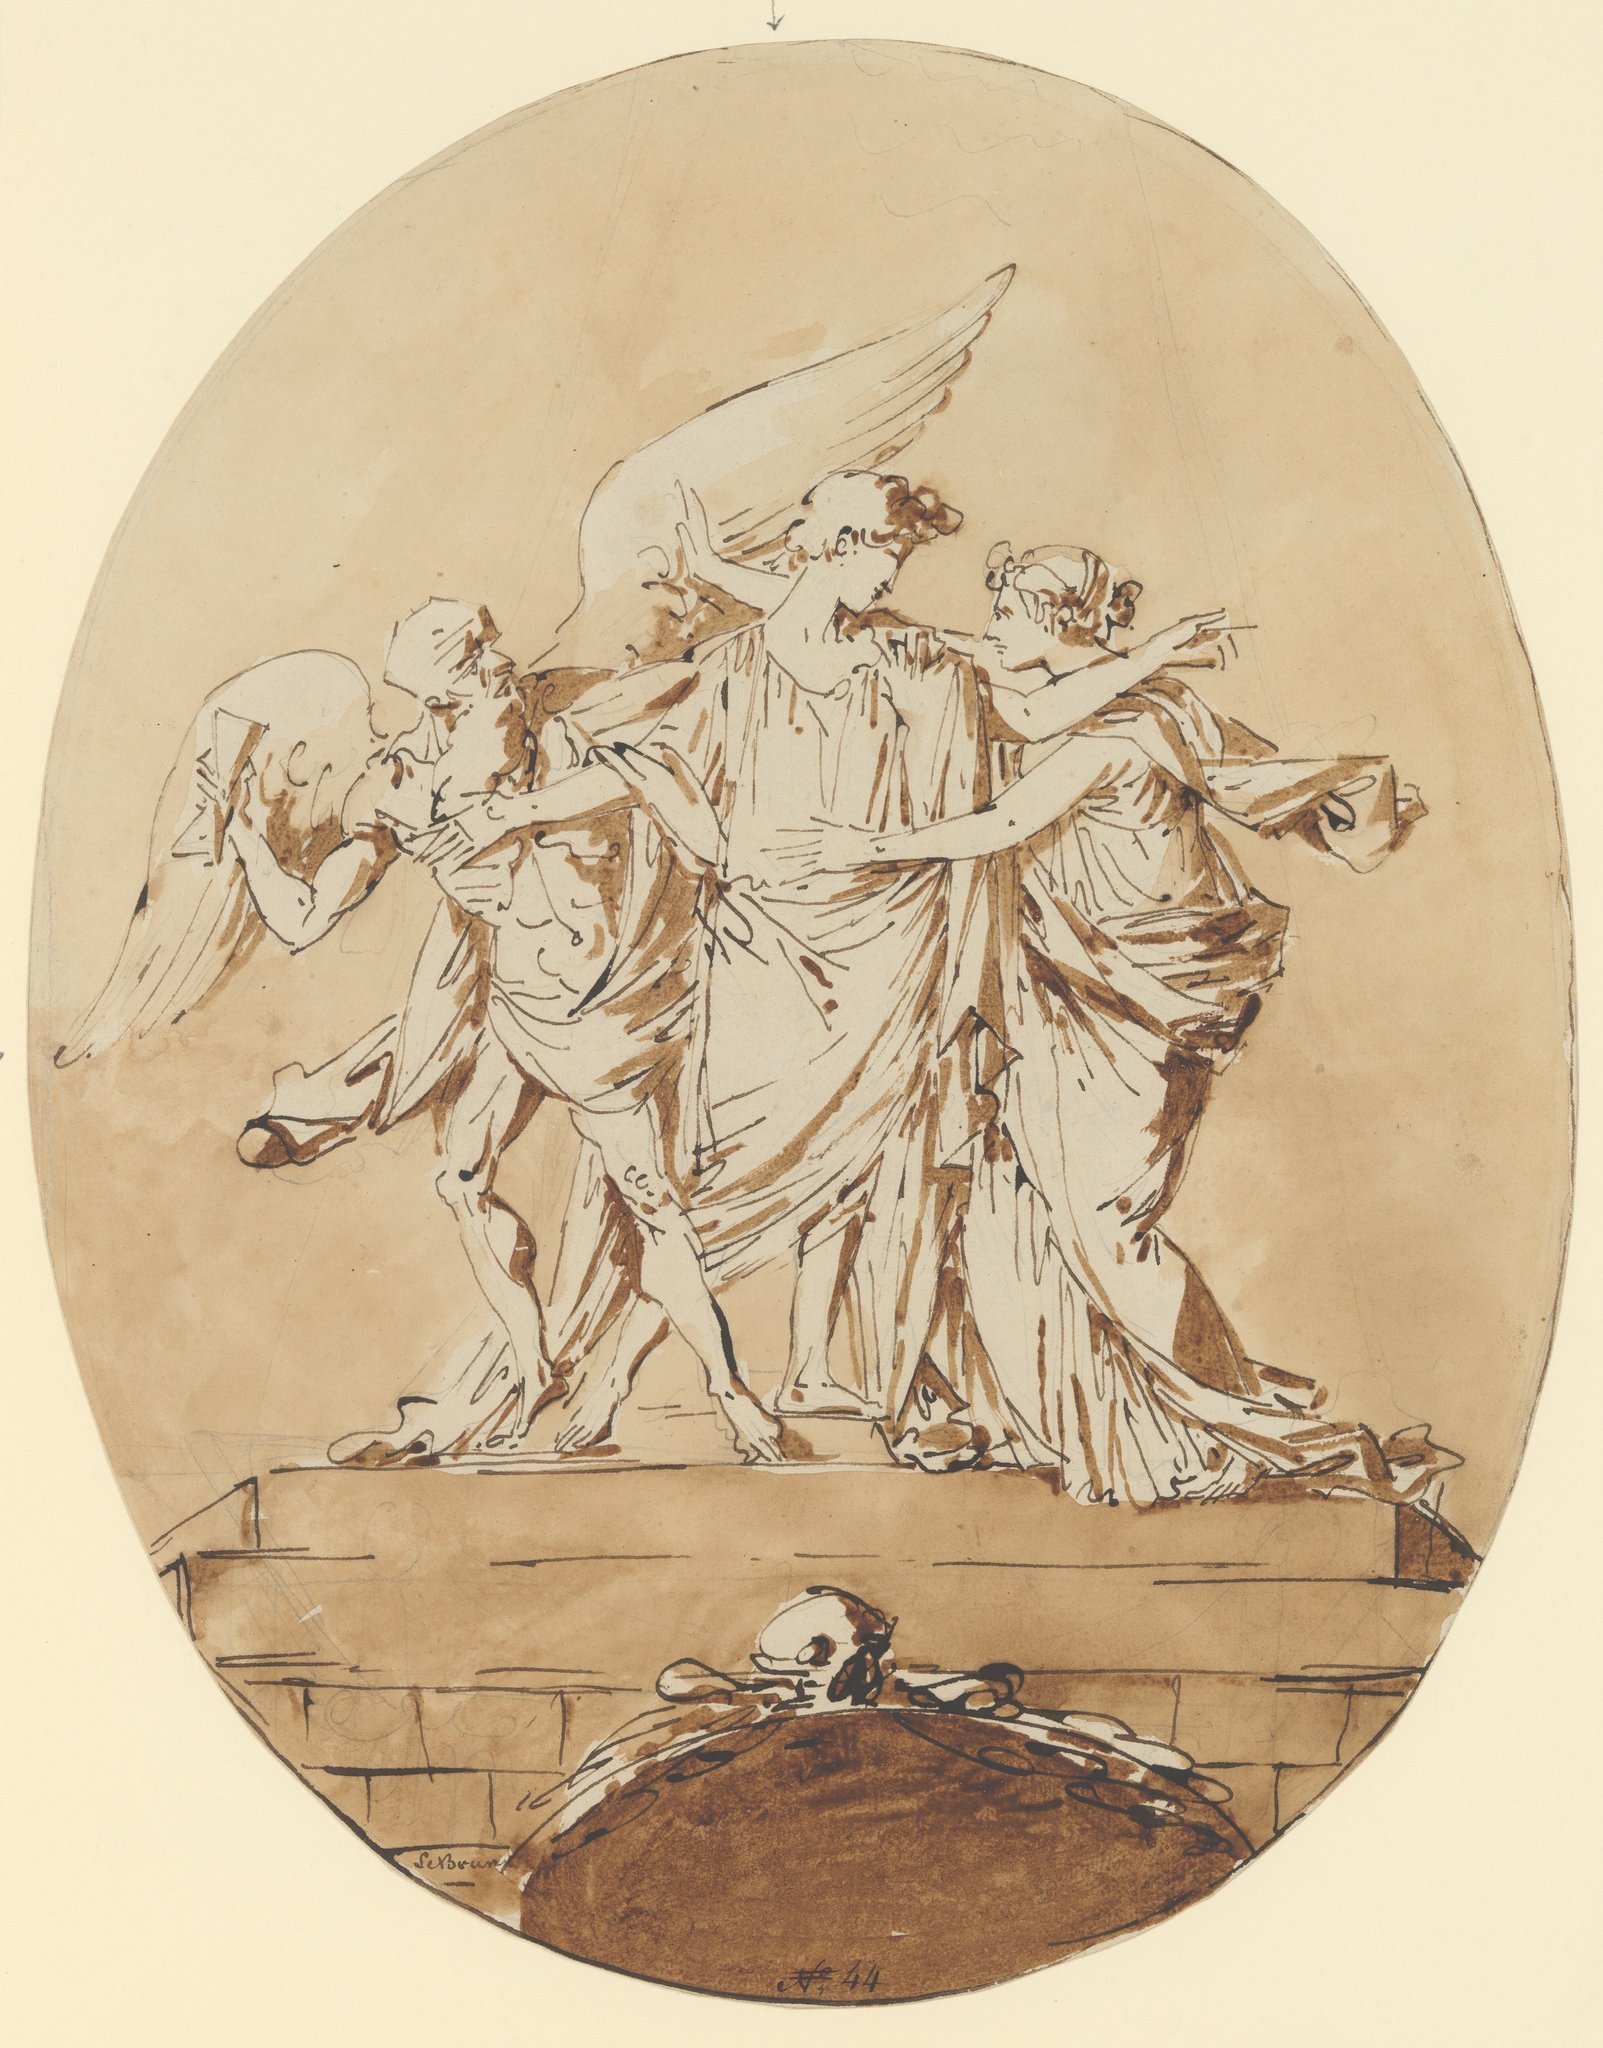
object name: drawing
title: Allegorical Design for a Tomb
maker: andré lebrun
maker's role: artist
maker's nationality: french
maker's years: 1737-1811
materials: graphite, ink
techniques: pen, wash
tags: men,women